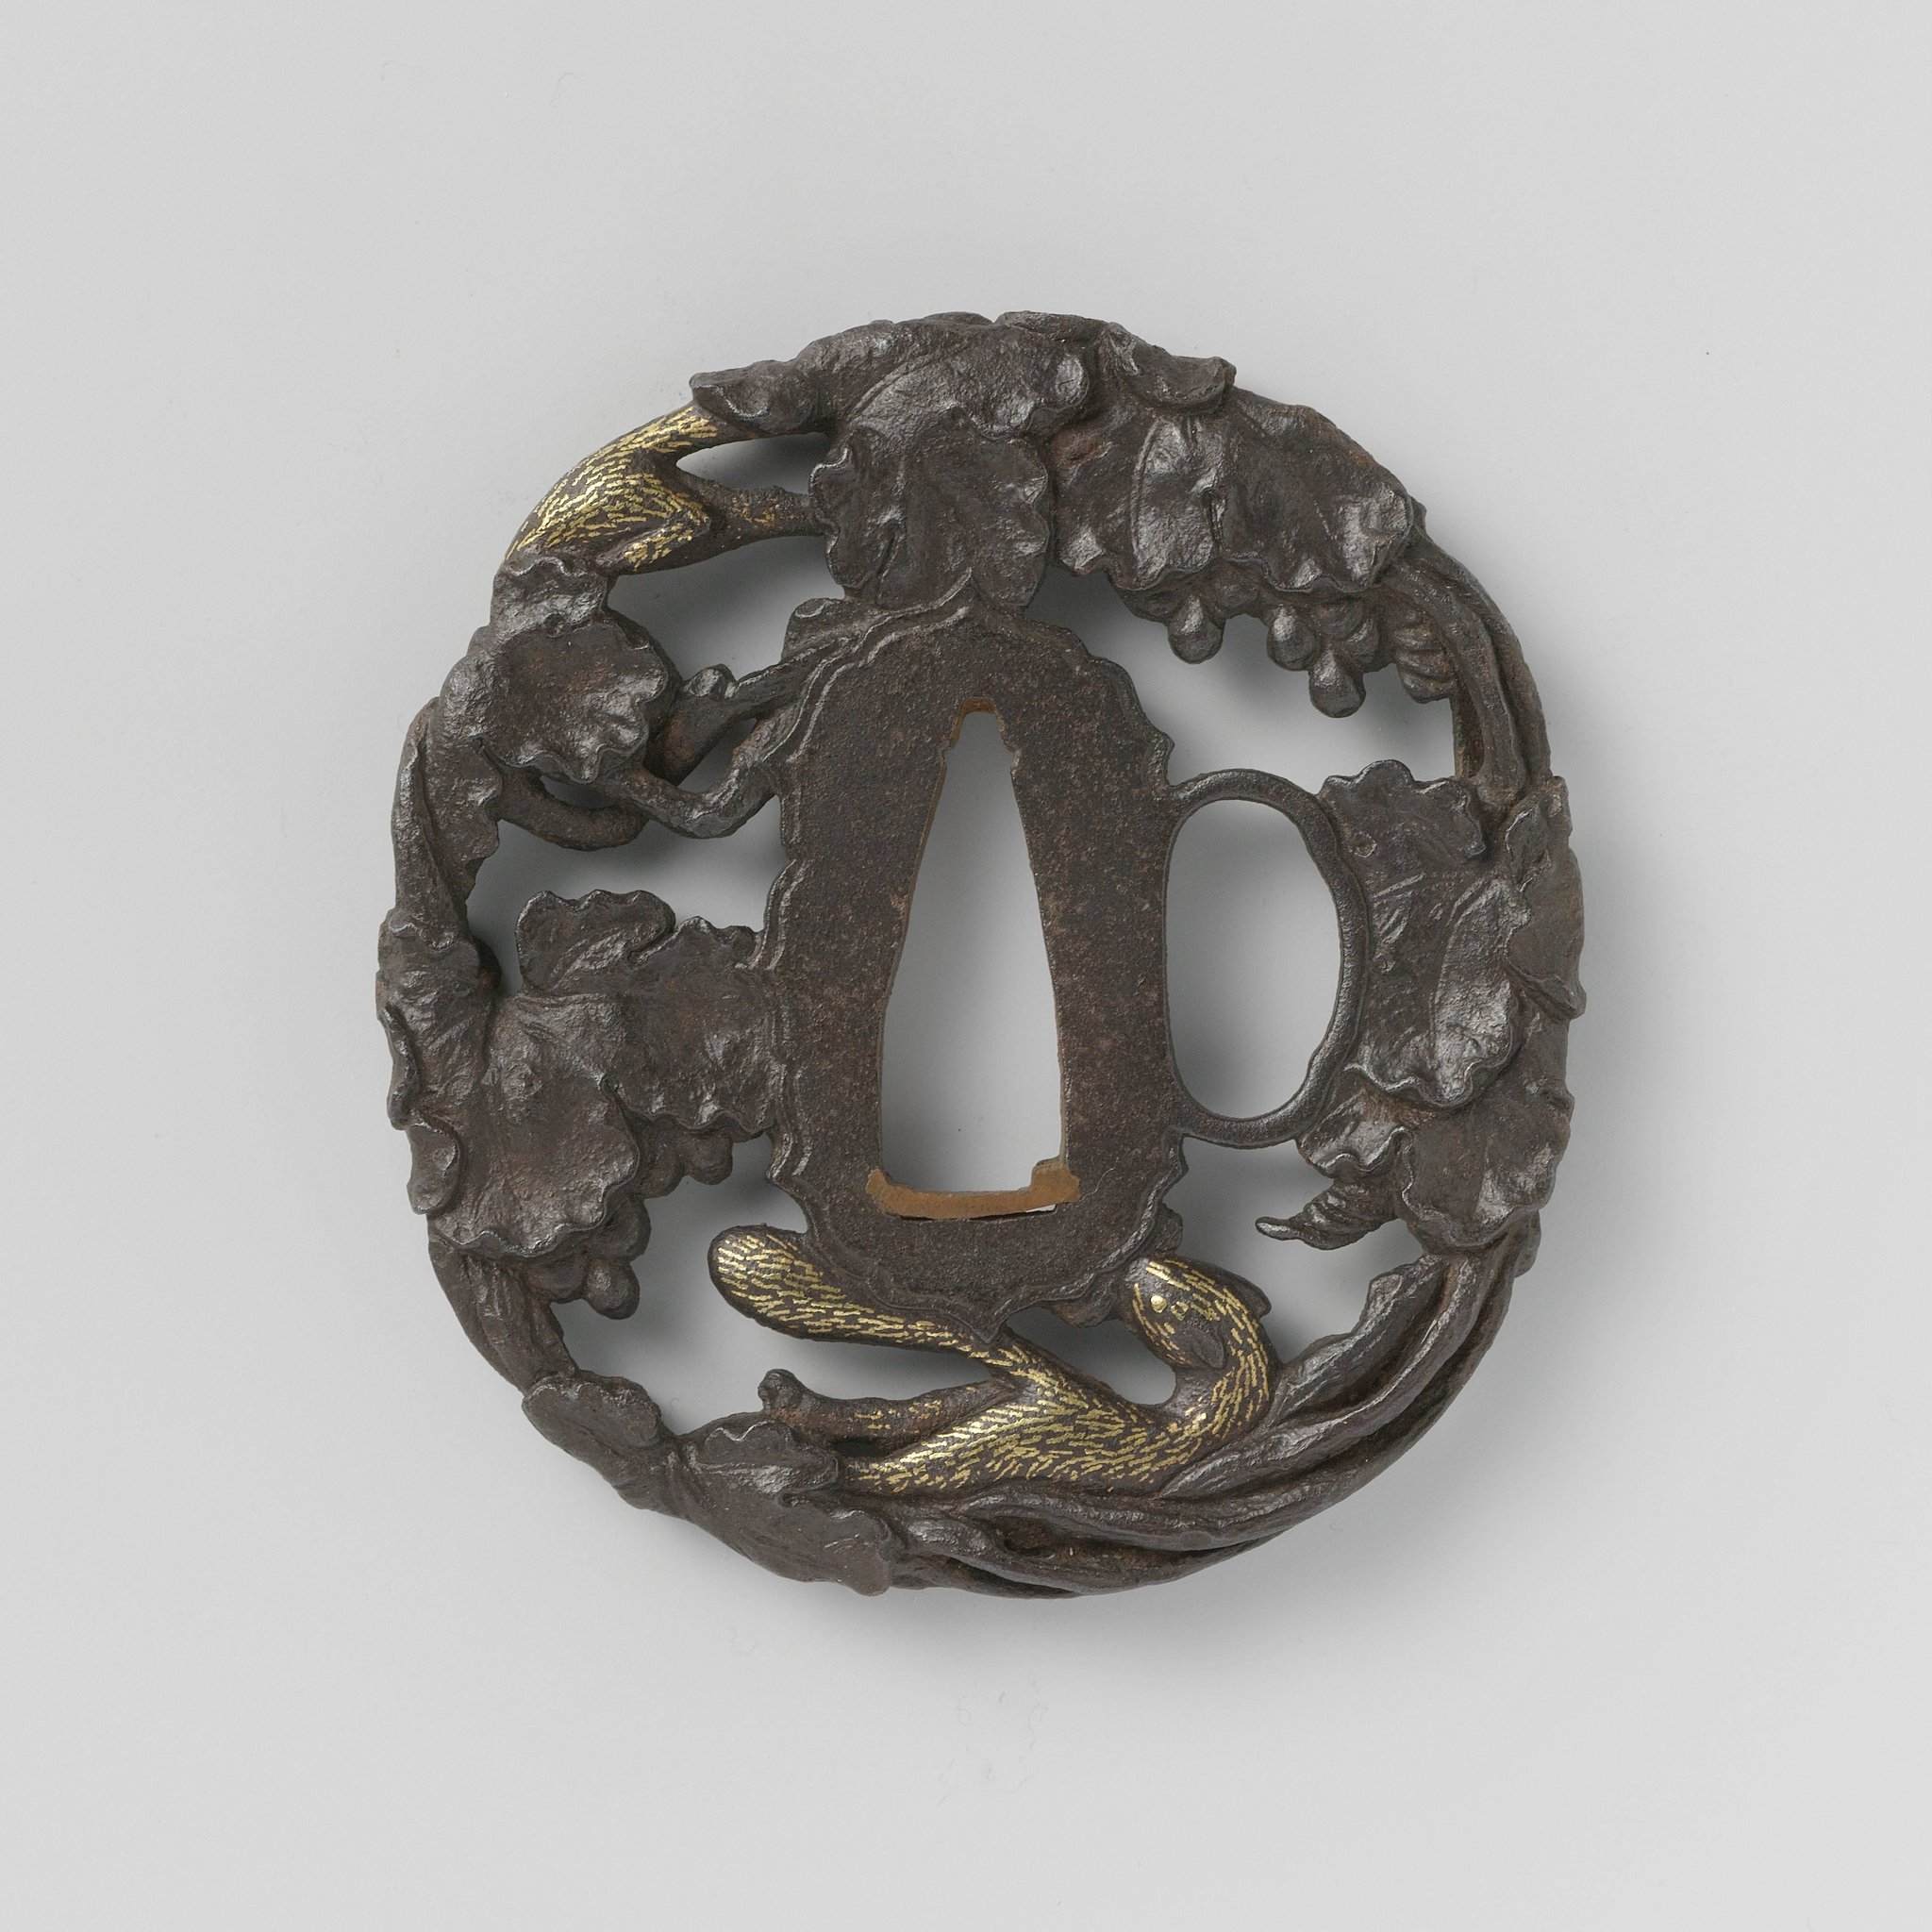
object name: tsuba, zwaardstootplaat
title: Hand guard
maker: Anonymous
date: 1600-1900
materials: gold, iron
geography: japan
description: Ovale tsuba met een onregelmatig gevormde rand in de vorm van twee eekhoorns temidden van wijnranken; de vacht de eekhoorns is weergegeven in goud nunome-zogan.